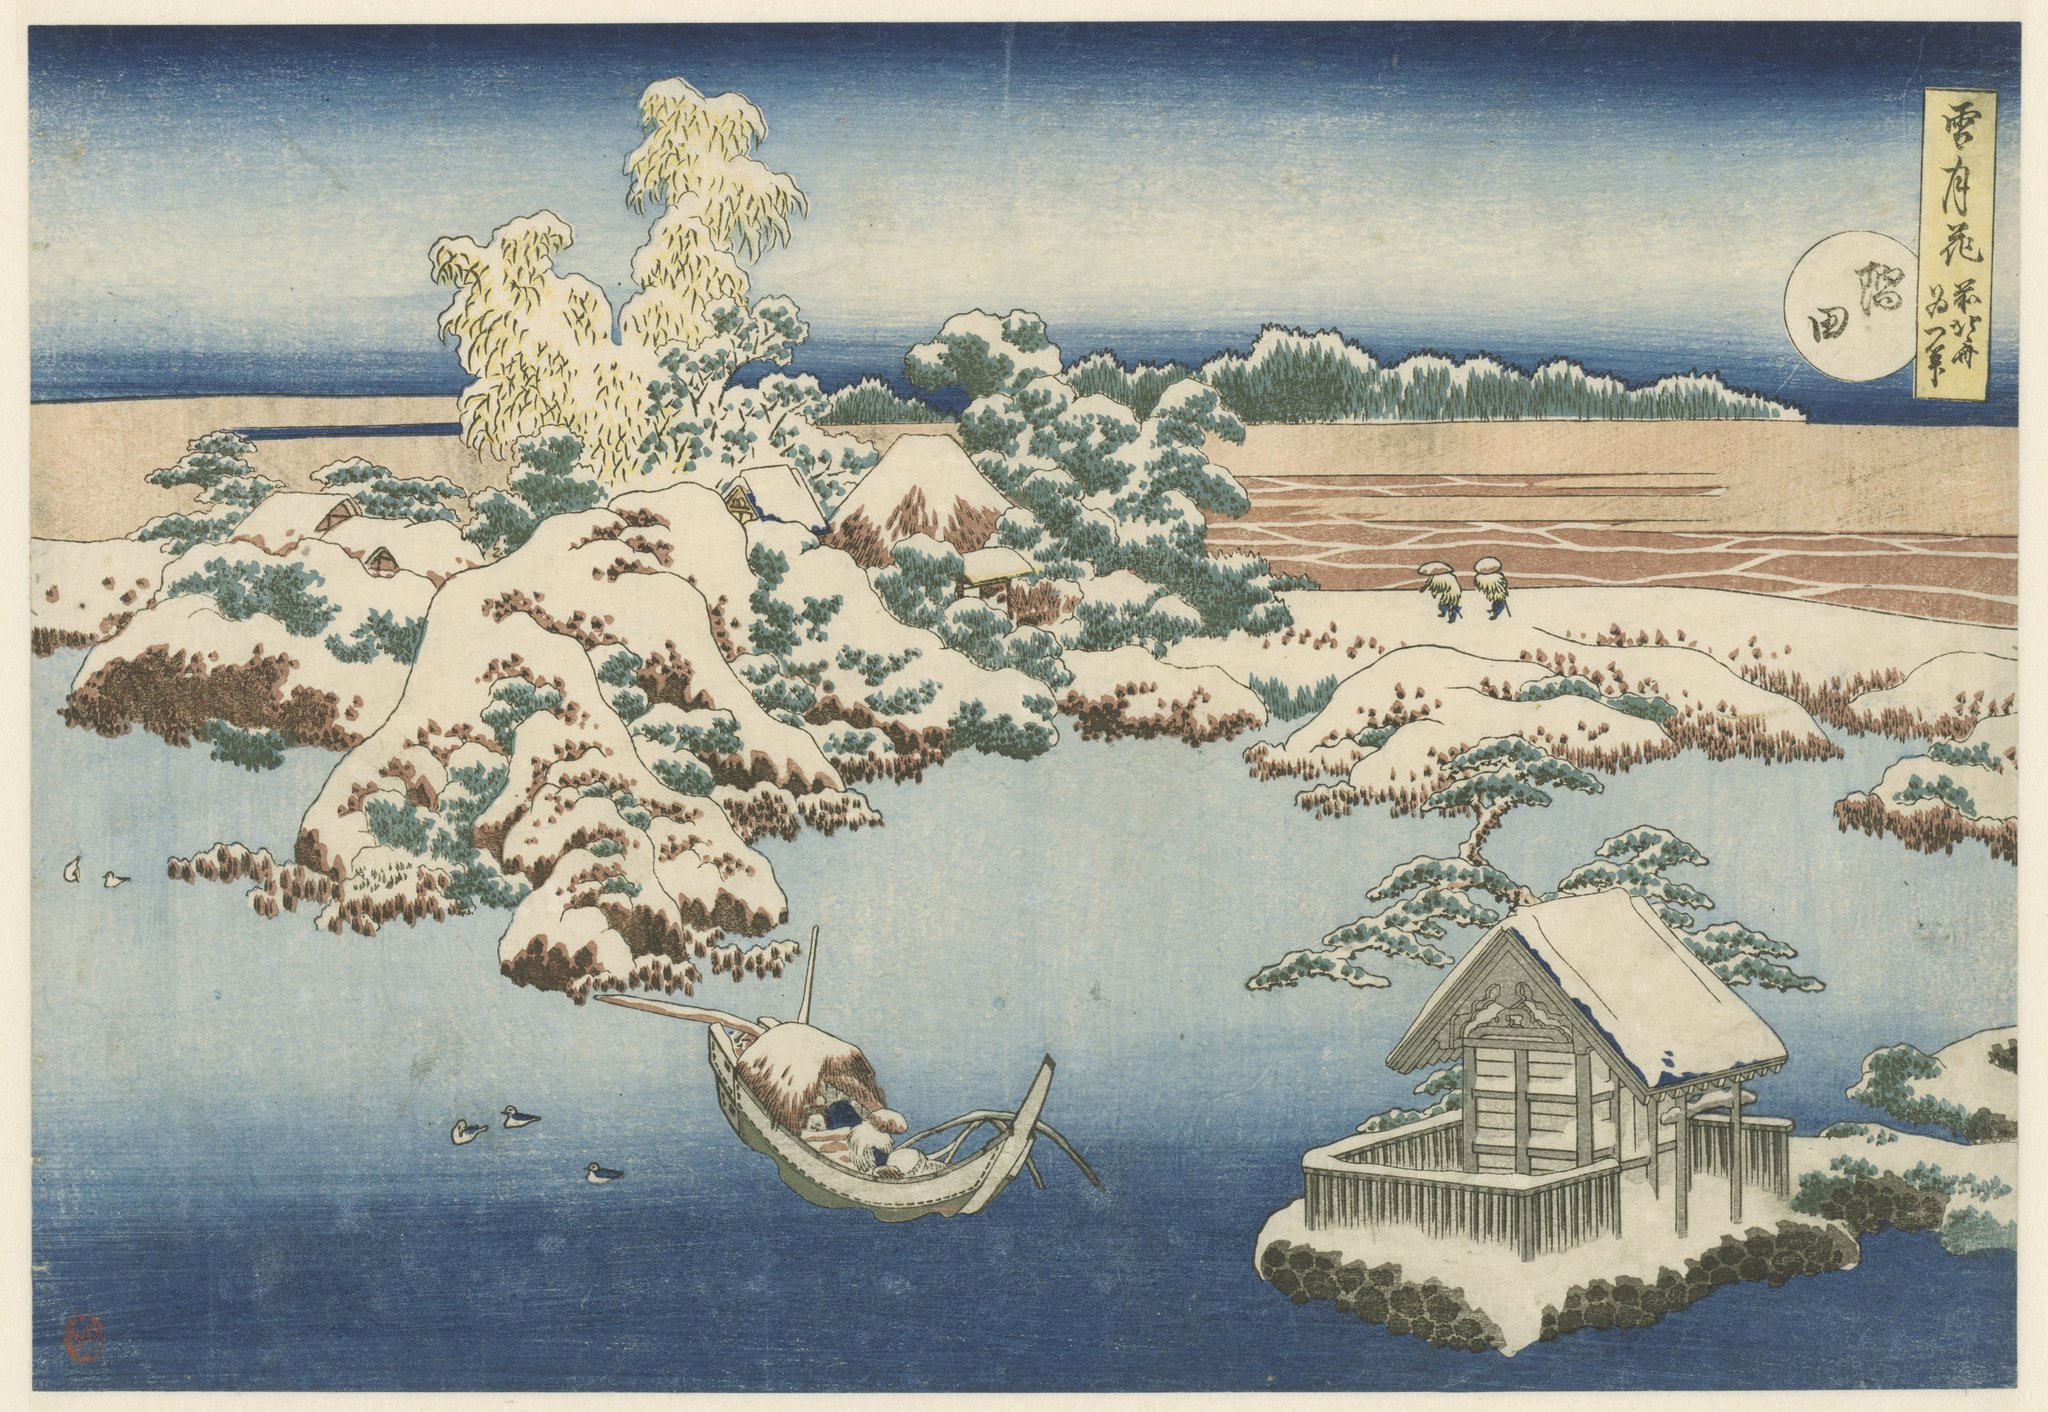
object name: print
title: De Sumida rivier in sneeuw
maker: katsushika hokusai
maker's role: draughtsman, print maker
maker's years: 1760-1849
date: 1831-1835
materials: paper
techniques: woodcut, nishiki e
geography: tokyo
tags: river, snow, temple, shrine ~ non-christian religions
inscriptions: collector's mark: Lugt 2972a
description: Rivierlandschap met besneeuwde oever; op de voorgrond een vissersboot en een heiligdom onder een pijnboom.